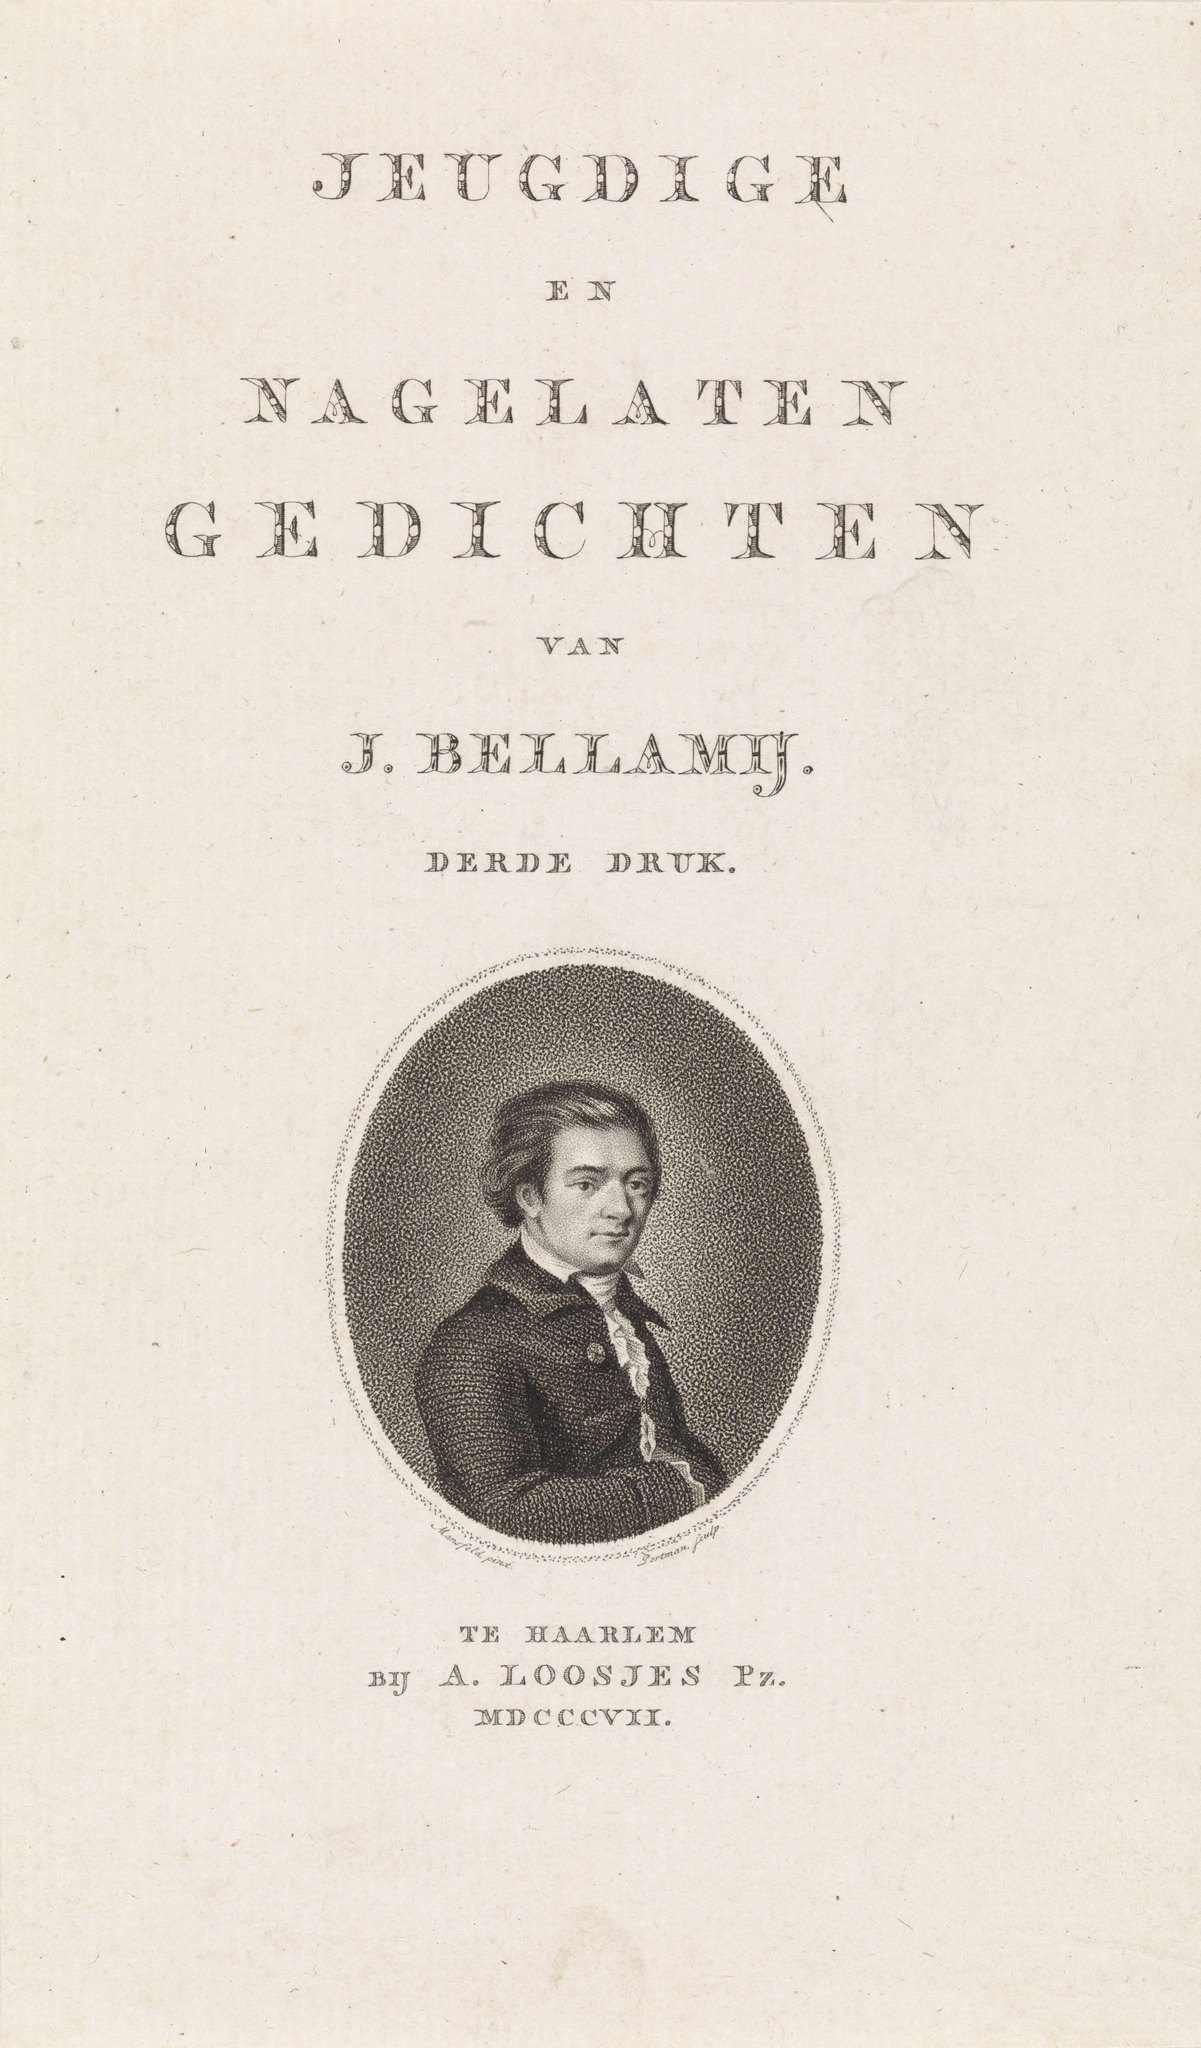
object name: titelblad, titelpagina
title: Titelpagina voor: J. Bellamy, Jeugdige en nagelaten gedichten, 1807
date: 1807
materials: paper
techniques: stippled etching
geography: amsterdam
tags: flushing, utrecht, portrait of a writer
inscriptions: collector's mark: Lugt 2228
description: Titelpagina voor: Bellamy, Jacobus. Jeugdige en nagelaten gedichten van J. Bellamij. Haarlem: Adriaan Pietersz. Loosjes, 1807.